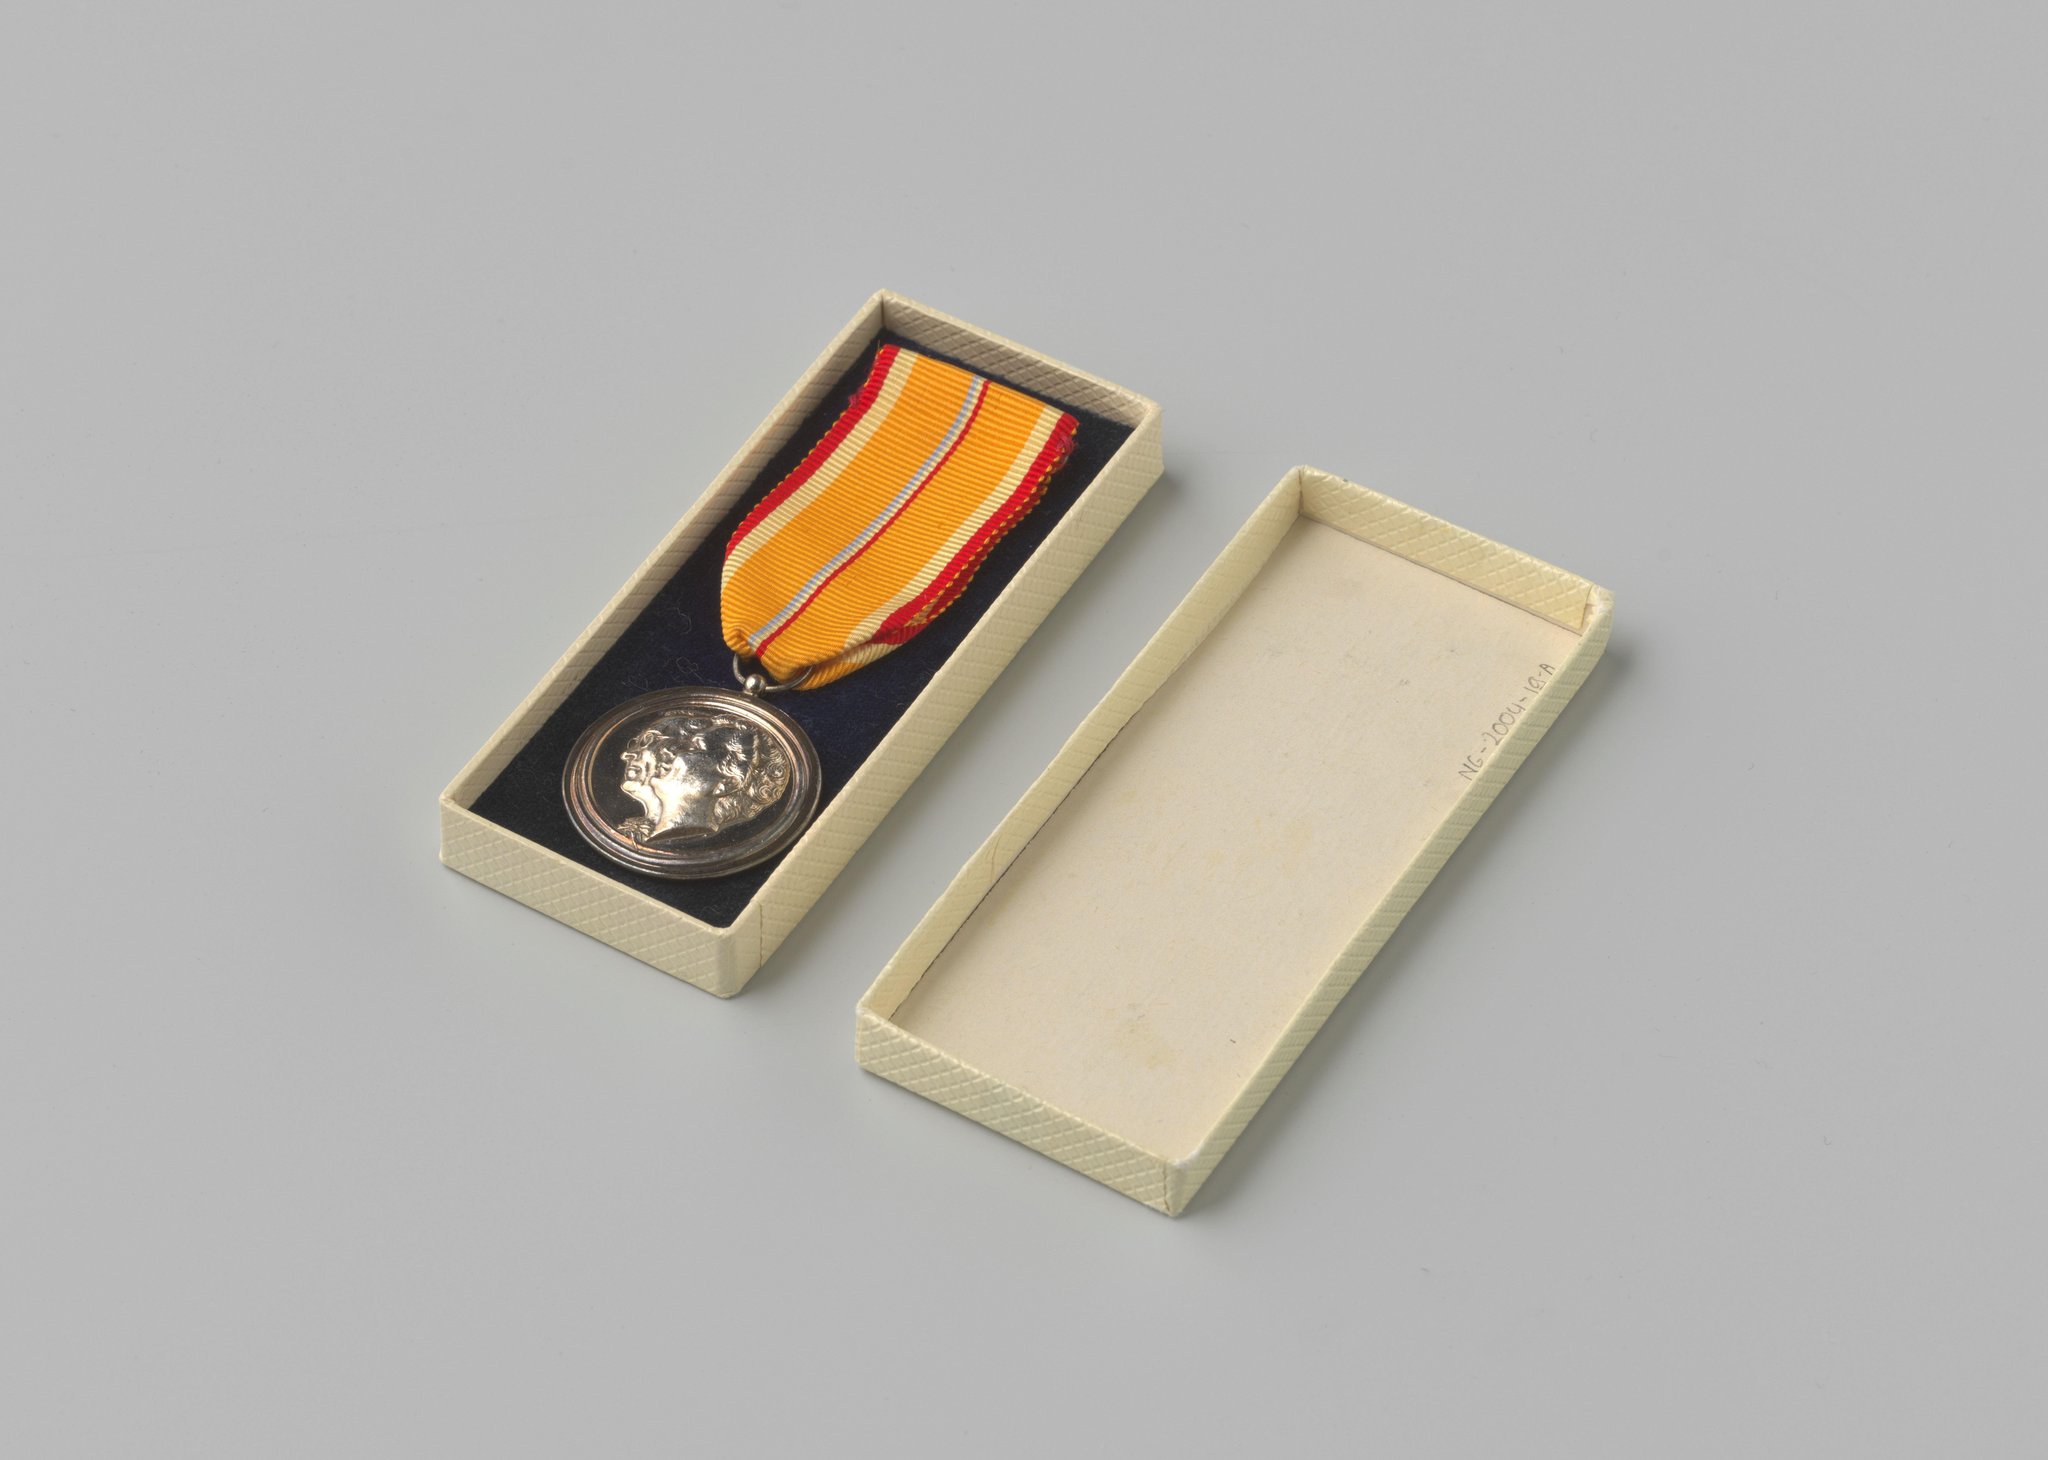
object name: draagpenning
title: Herinneringspenning bij het zilveren, vijfentwintigjarig huwelijk van koningin Juliana en prins Bernhard, 1962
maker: Anonymous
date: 1901-1962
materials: silver, textile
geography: netherlands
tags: utrecht, bernhard (prins der nederlanden), amsterdam, the hague, willem drees, juliana of the netherlands, netherlands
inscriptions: circumscription: ‘7 JANUARI 1937 1962’, inscription: ‘25 JB’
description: Zilveren penning aan draagring en oranje lint met rood-geel-blauwe strepen in het midden en geel-rode strepen aan de zijkanten, aan speld. Voorzijde: Juliana en Bernhard met anjer, met profiel naar links, binnen twee geschakelde ringen. Keerzijde: gekroonde 25 JB en aan de rand de datum 7 januari 1937 - 1962.